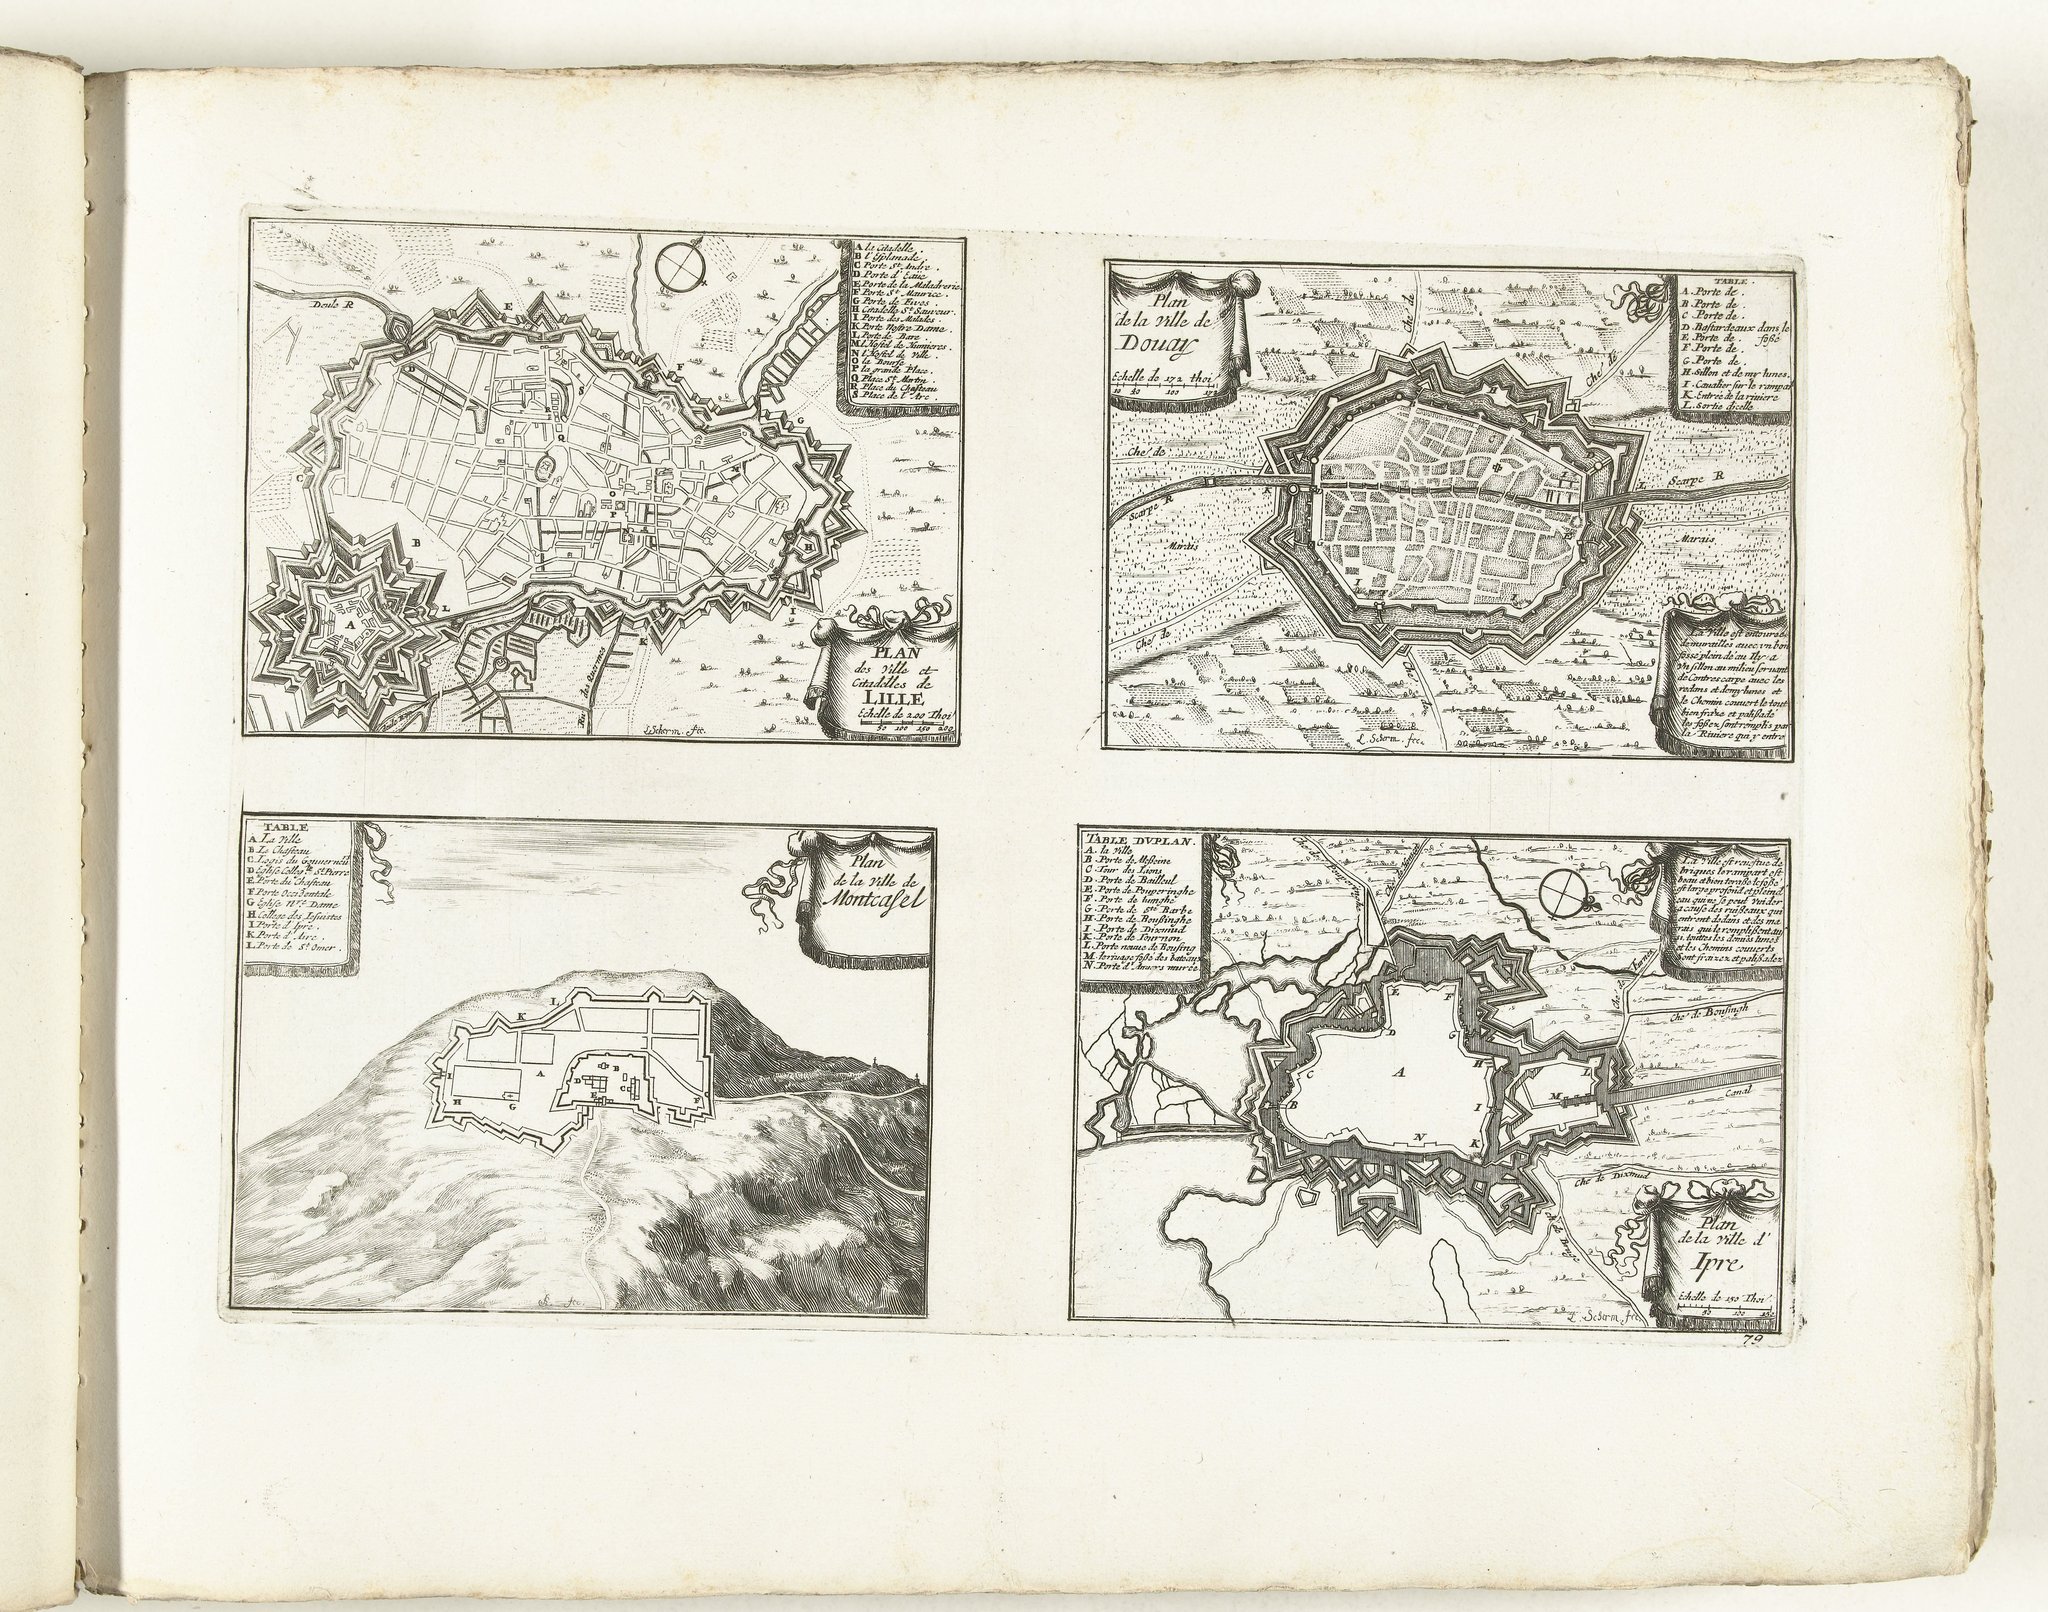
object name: map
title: Les Forces de l'Europe, Asie, Afrique et Amerique, ou description des principales villes avec leurs fortifications. Dessignées par les meilleurs ingenieurs, particulierement celles qui sont sous la domination de la France (...) et ornées de plusieurs superbes edifices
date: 1702-1703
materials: paper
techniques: etching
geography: amsterdam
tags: fortress, maps of cities, lille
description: Blad met vier plattegronden van de versterkingen om de steden Lille, Douai, Montcassel (?) en Yperen. Plaat nr. 79 in het prentwerk bestaande in totaal uit 276 genummerde platen van vermaarde sterke steden en vestingen in het kader van de Spaanse Successieoorlog. Voor het merendeel zijn deze platen gekopieerd naar de anonieme Franse platen: in Les forces de l'Europe en in: Le theatre de la guerre, dans les Pays-Bas, beide oorspronkelijk uitgegeven door Nicolas de Fer te Parijs (1693-1697) in het kader van de Negenjarige Oorlog. Titel en opschriften in de plaat in het Frans.